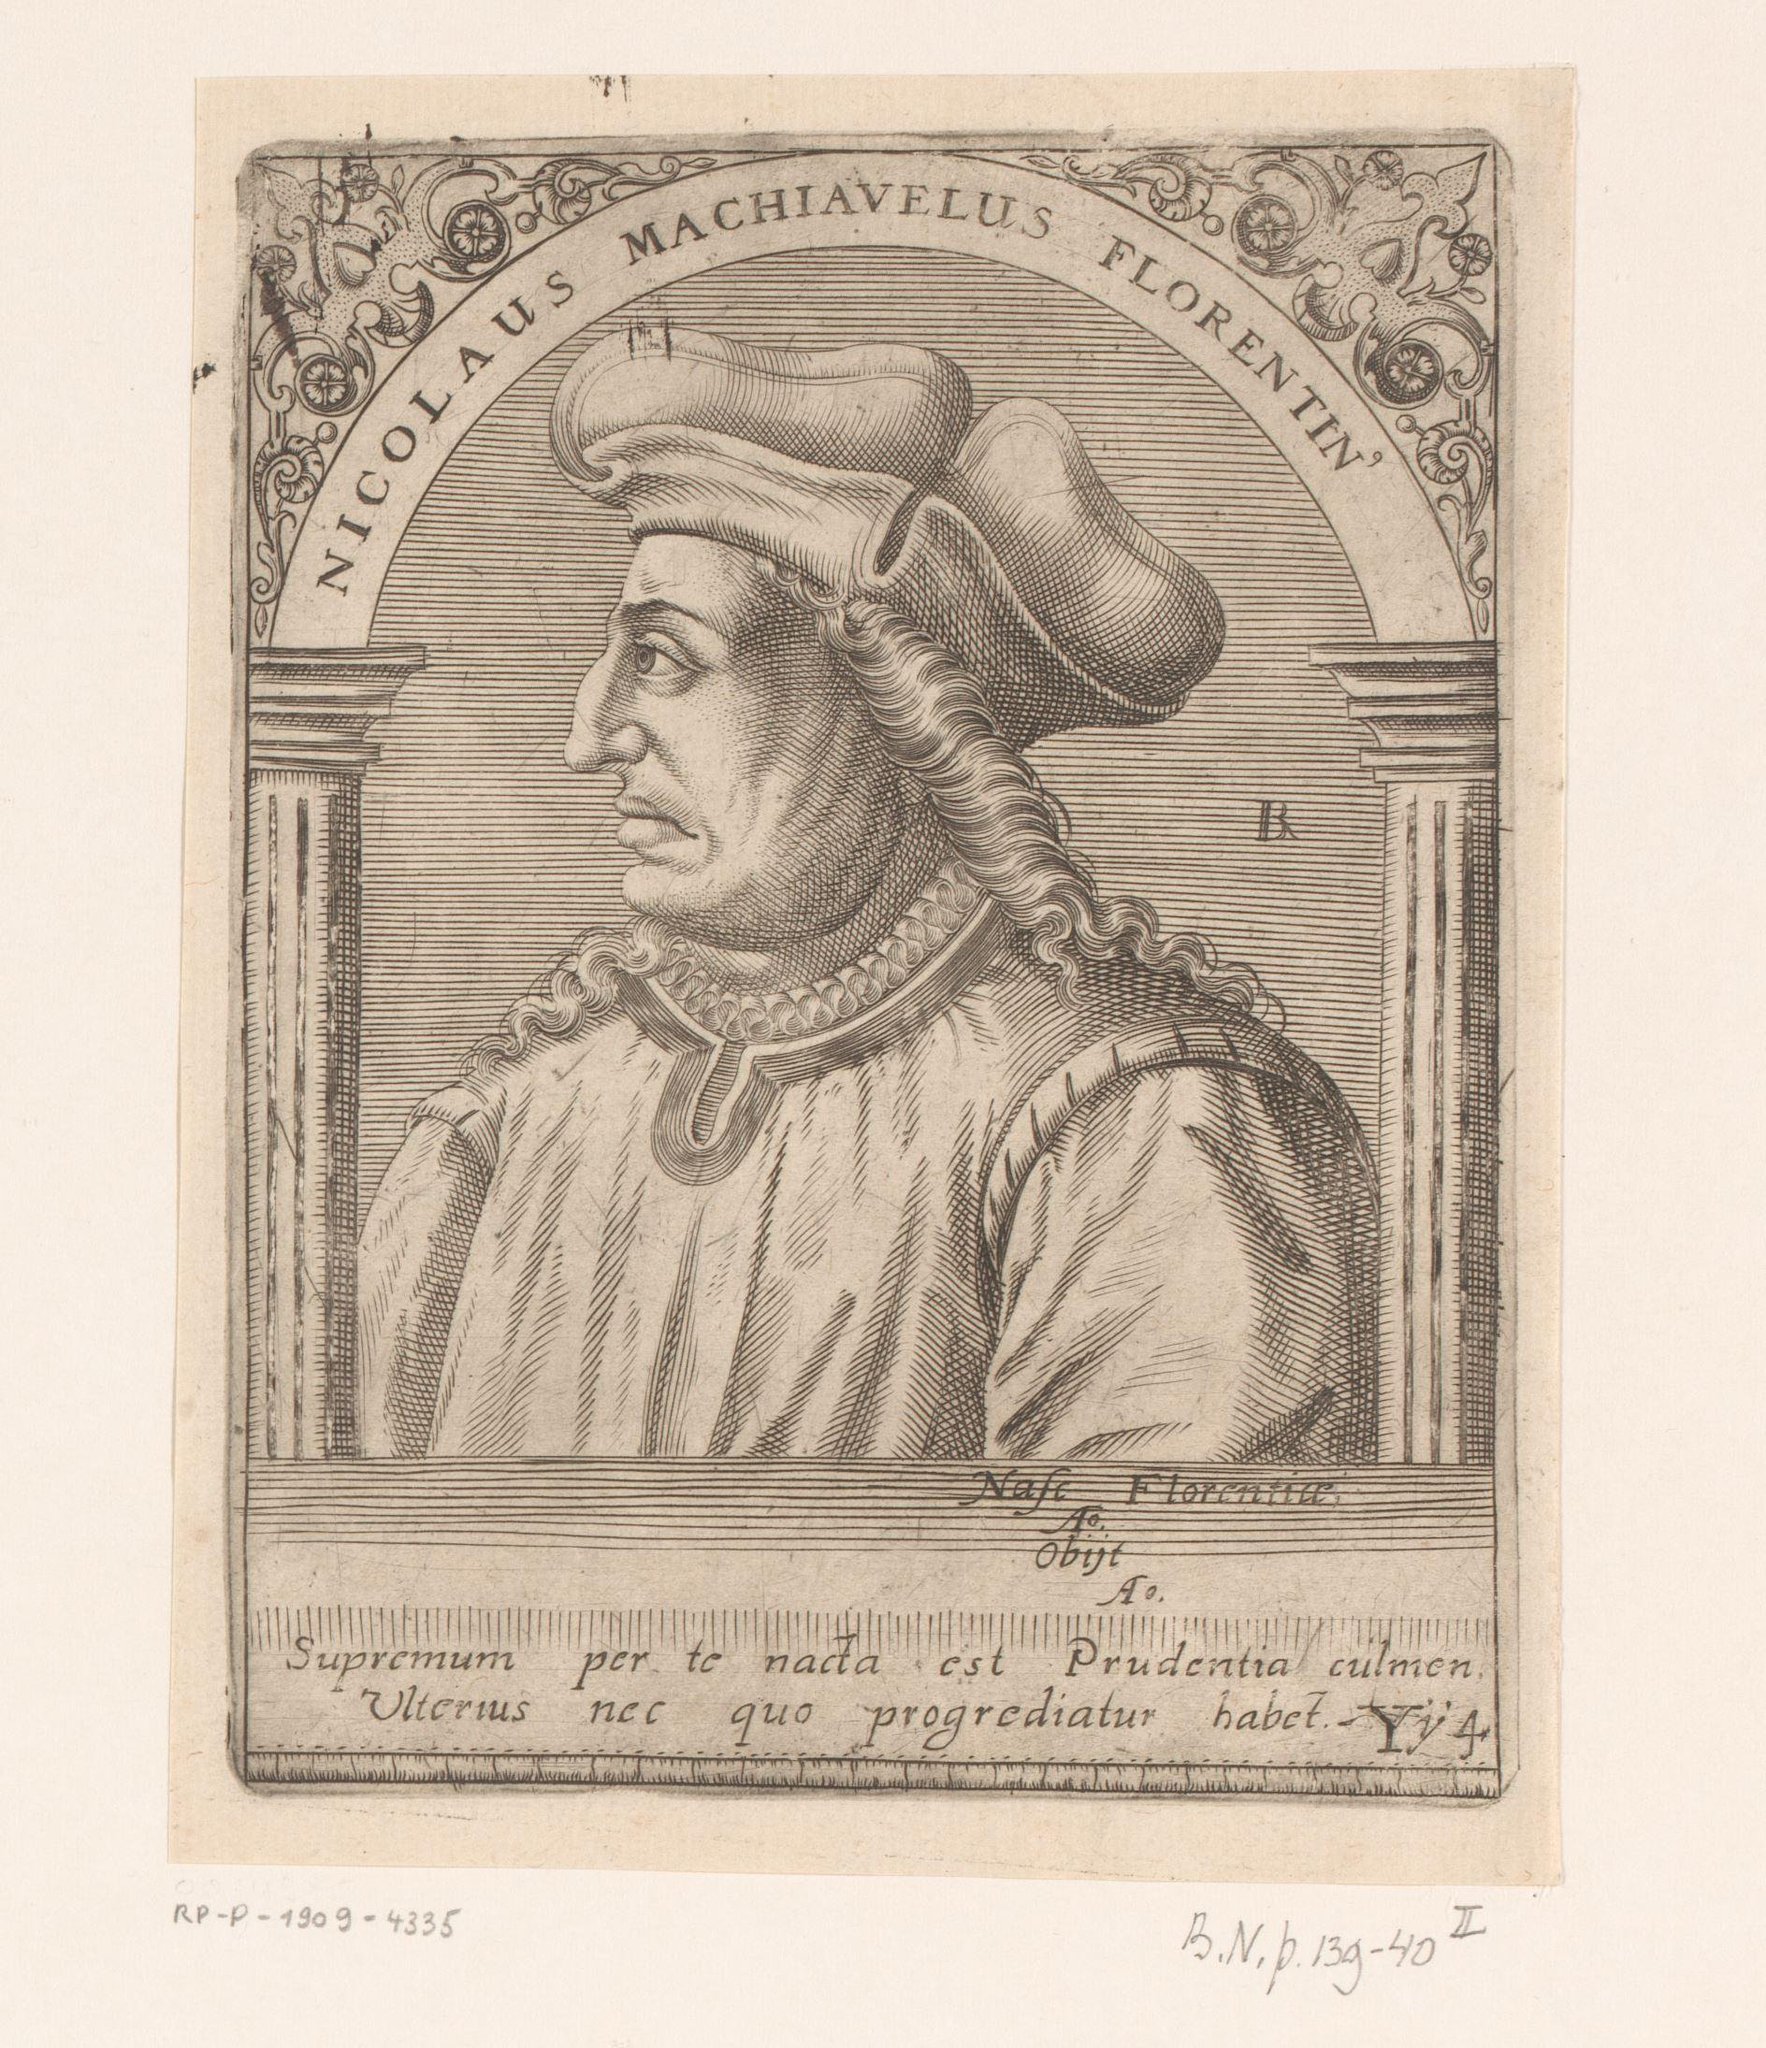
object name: print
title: Portret van Niccolò Machiavelli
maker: robert boissard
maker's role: print maker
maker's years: 1570-1611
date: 1597-1599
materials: paper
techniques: engraving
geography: france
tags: politician, historical persons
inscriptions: collector's mark: Lugt 2228